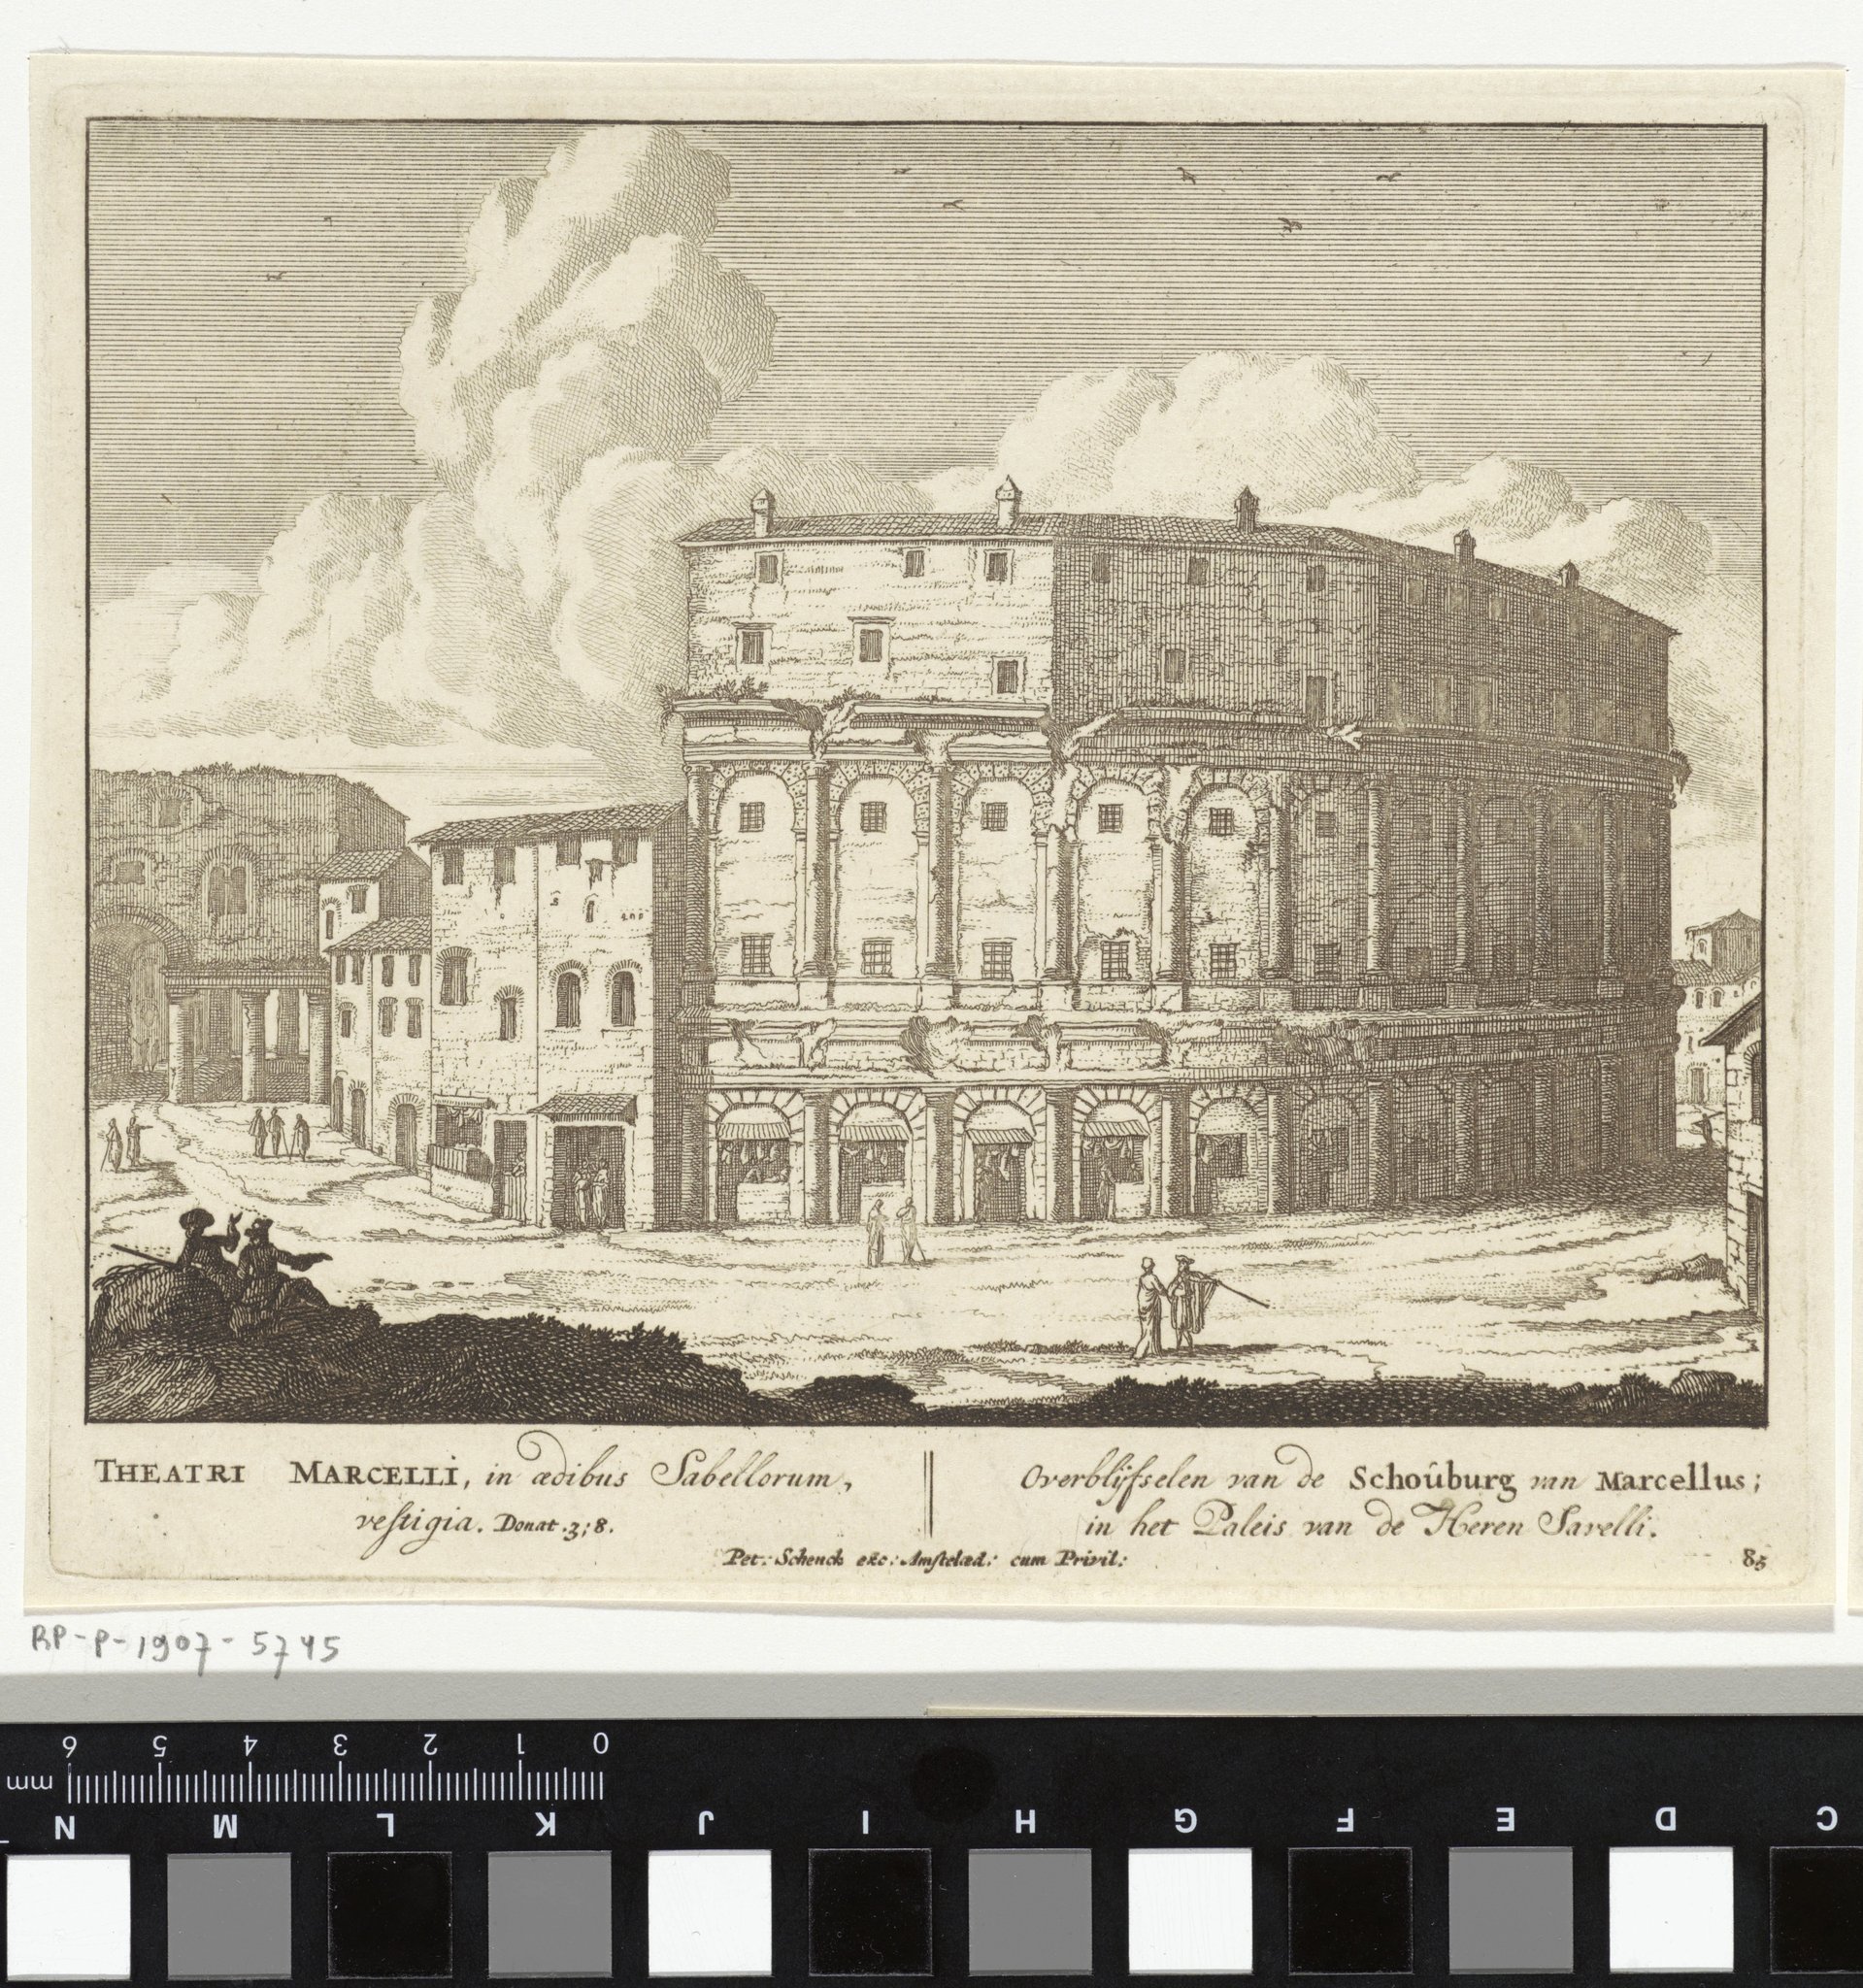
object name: print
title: Overblijfselen van de Schouburg van Mercellus; in het Paleis van de Heren Savelli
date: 1675-1711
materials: paper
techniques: etching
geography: amsterdam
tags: theatre (building), rome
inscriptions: collector's mark: Lugt 2228